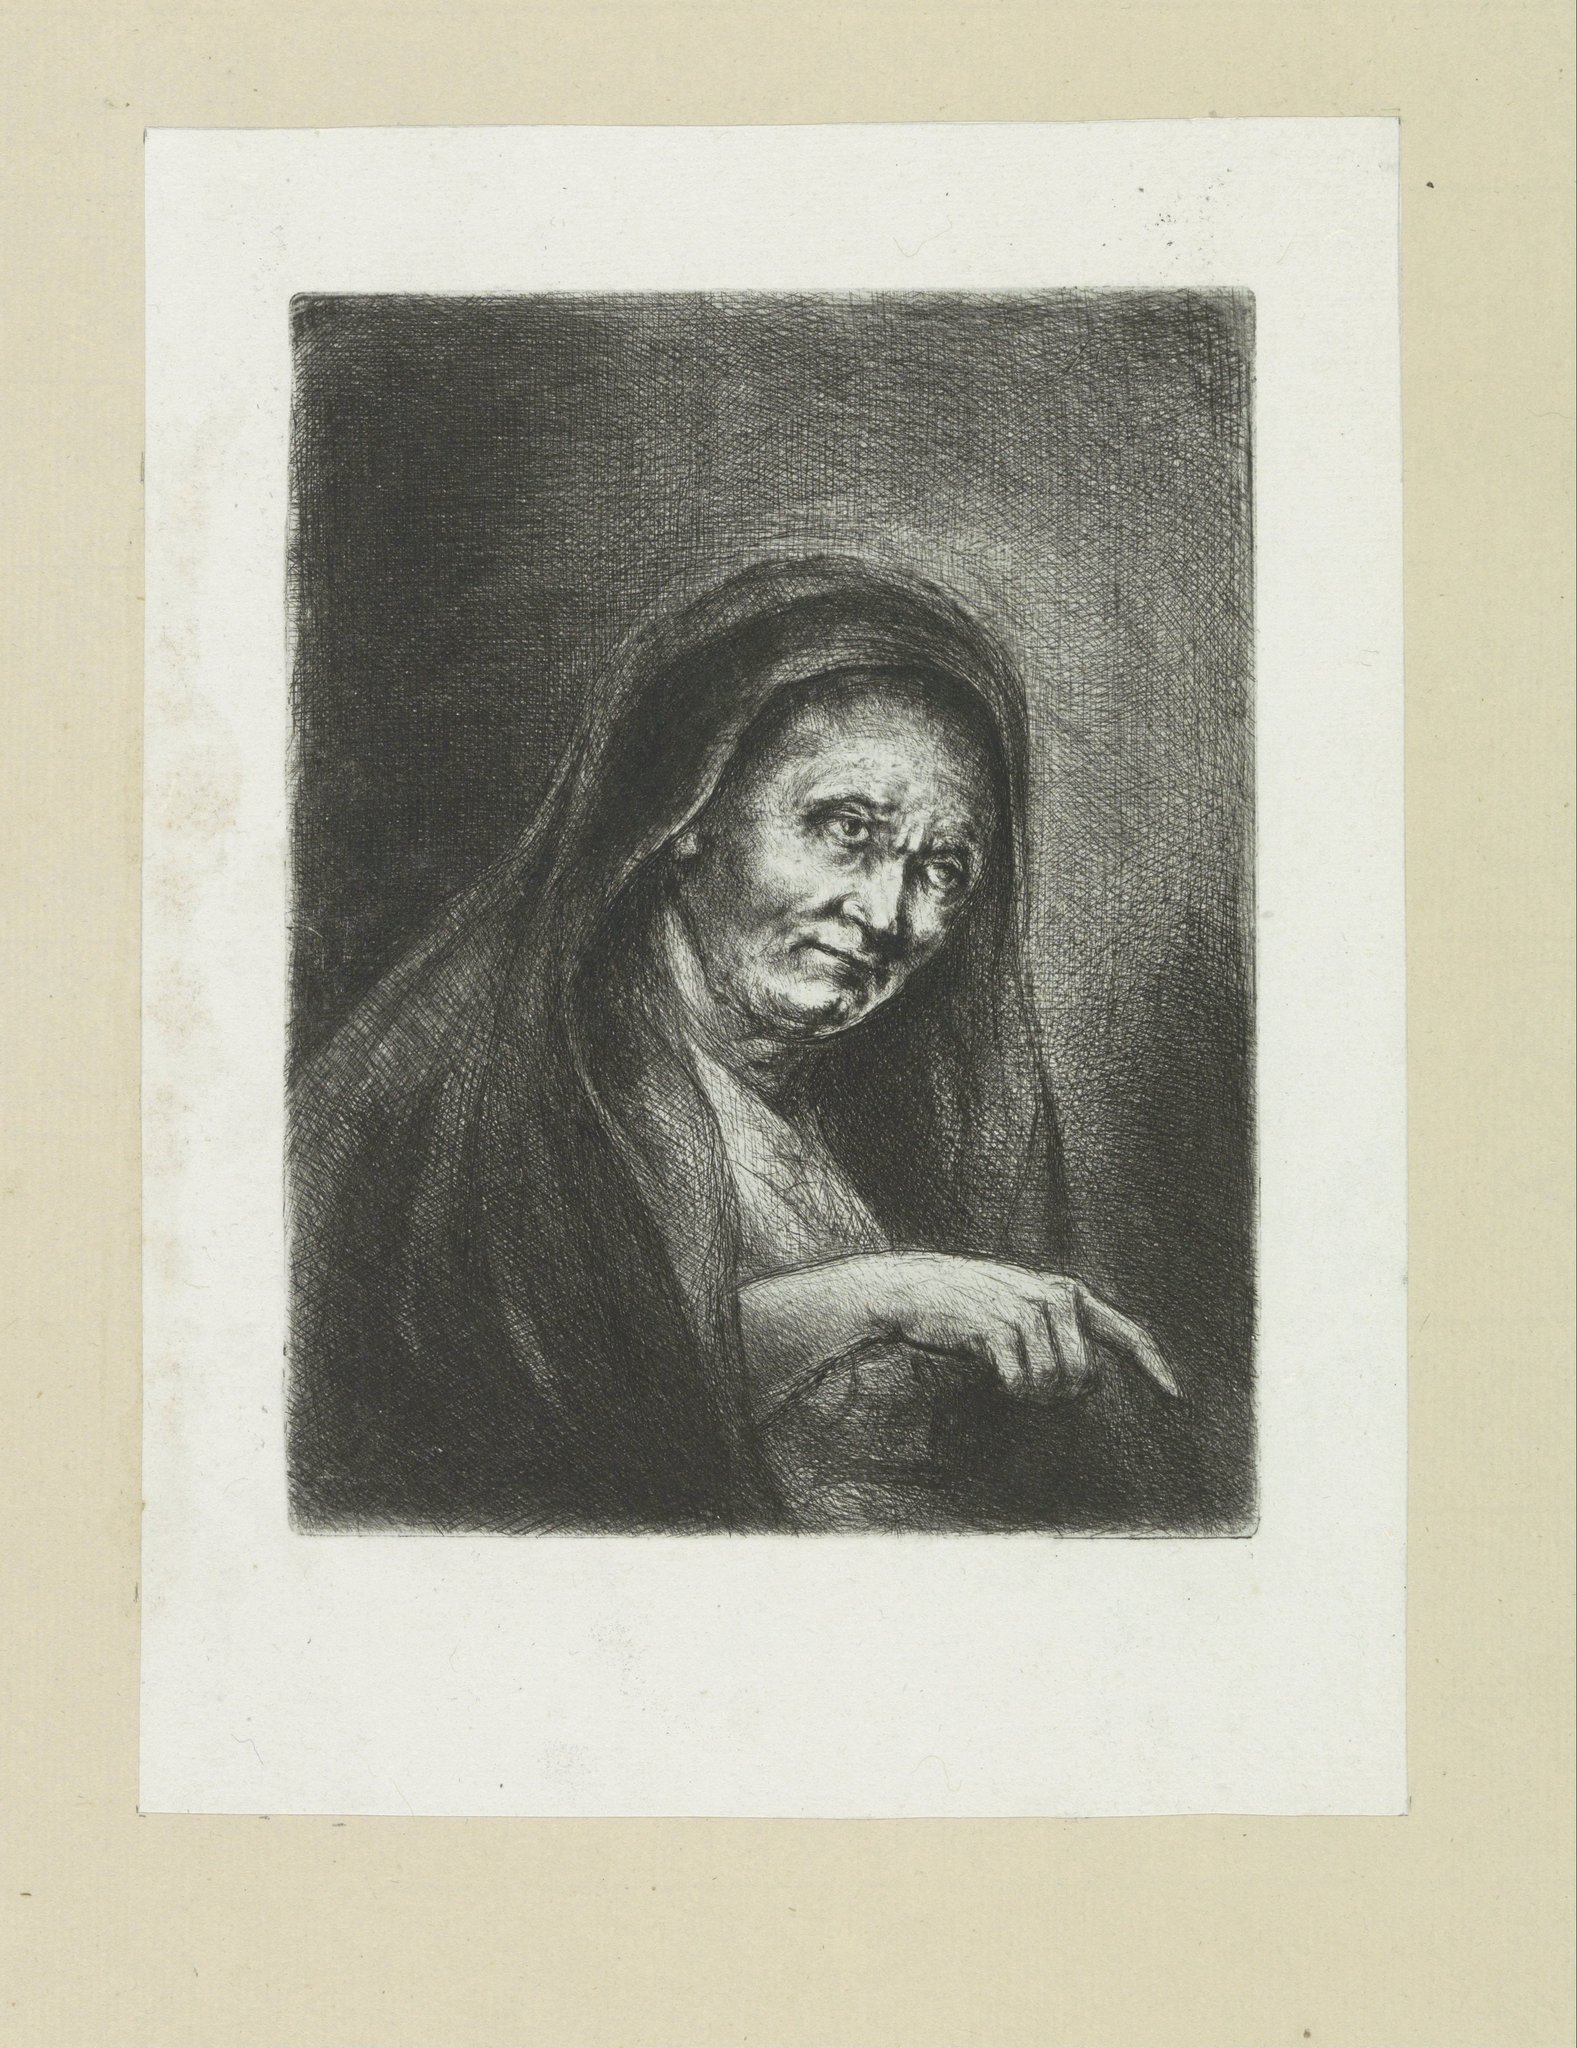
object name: print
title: Wijzende oude vrouw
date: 1802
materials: paper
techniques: drypoint, etching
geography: london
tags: old woman, veil, morphology of human expression (+ adult female (human being))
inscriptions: collector's mark: ‘B’, collector's mark: ‘RIJKS / MUSM’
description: Een oude vrouw. Ze draagt een hoofddoek en wijst naar rechts. De prent maakt deel uit van een album.